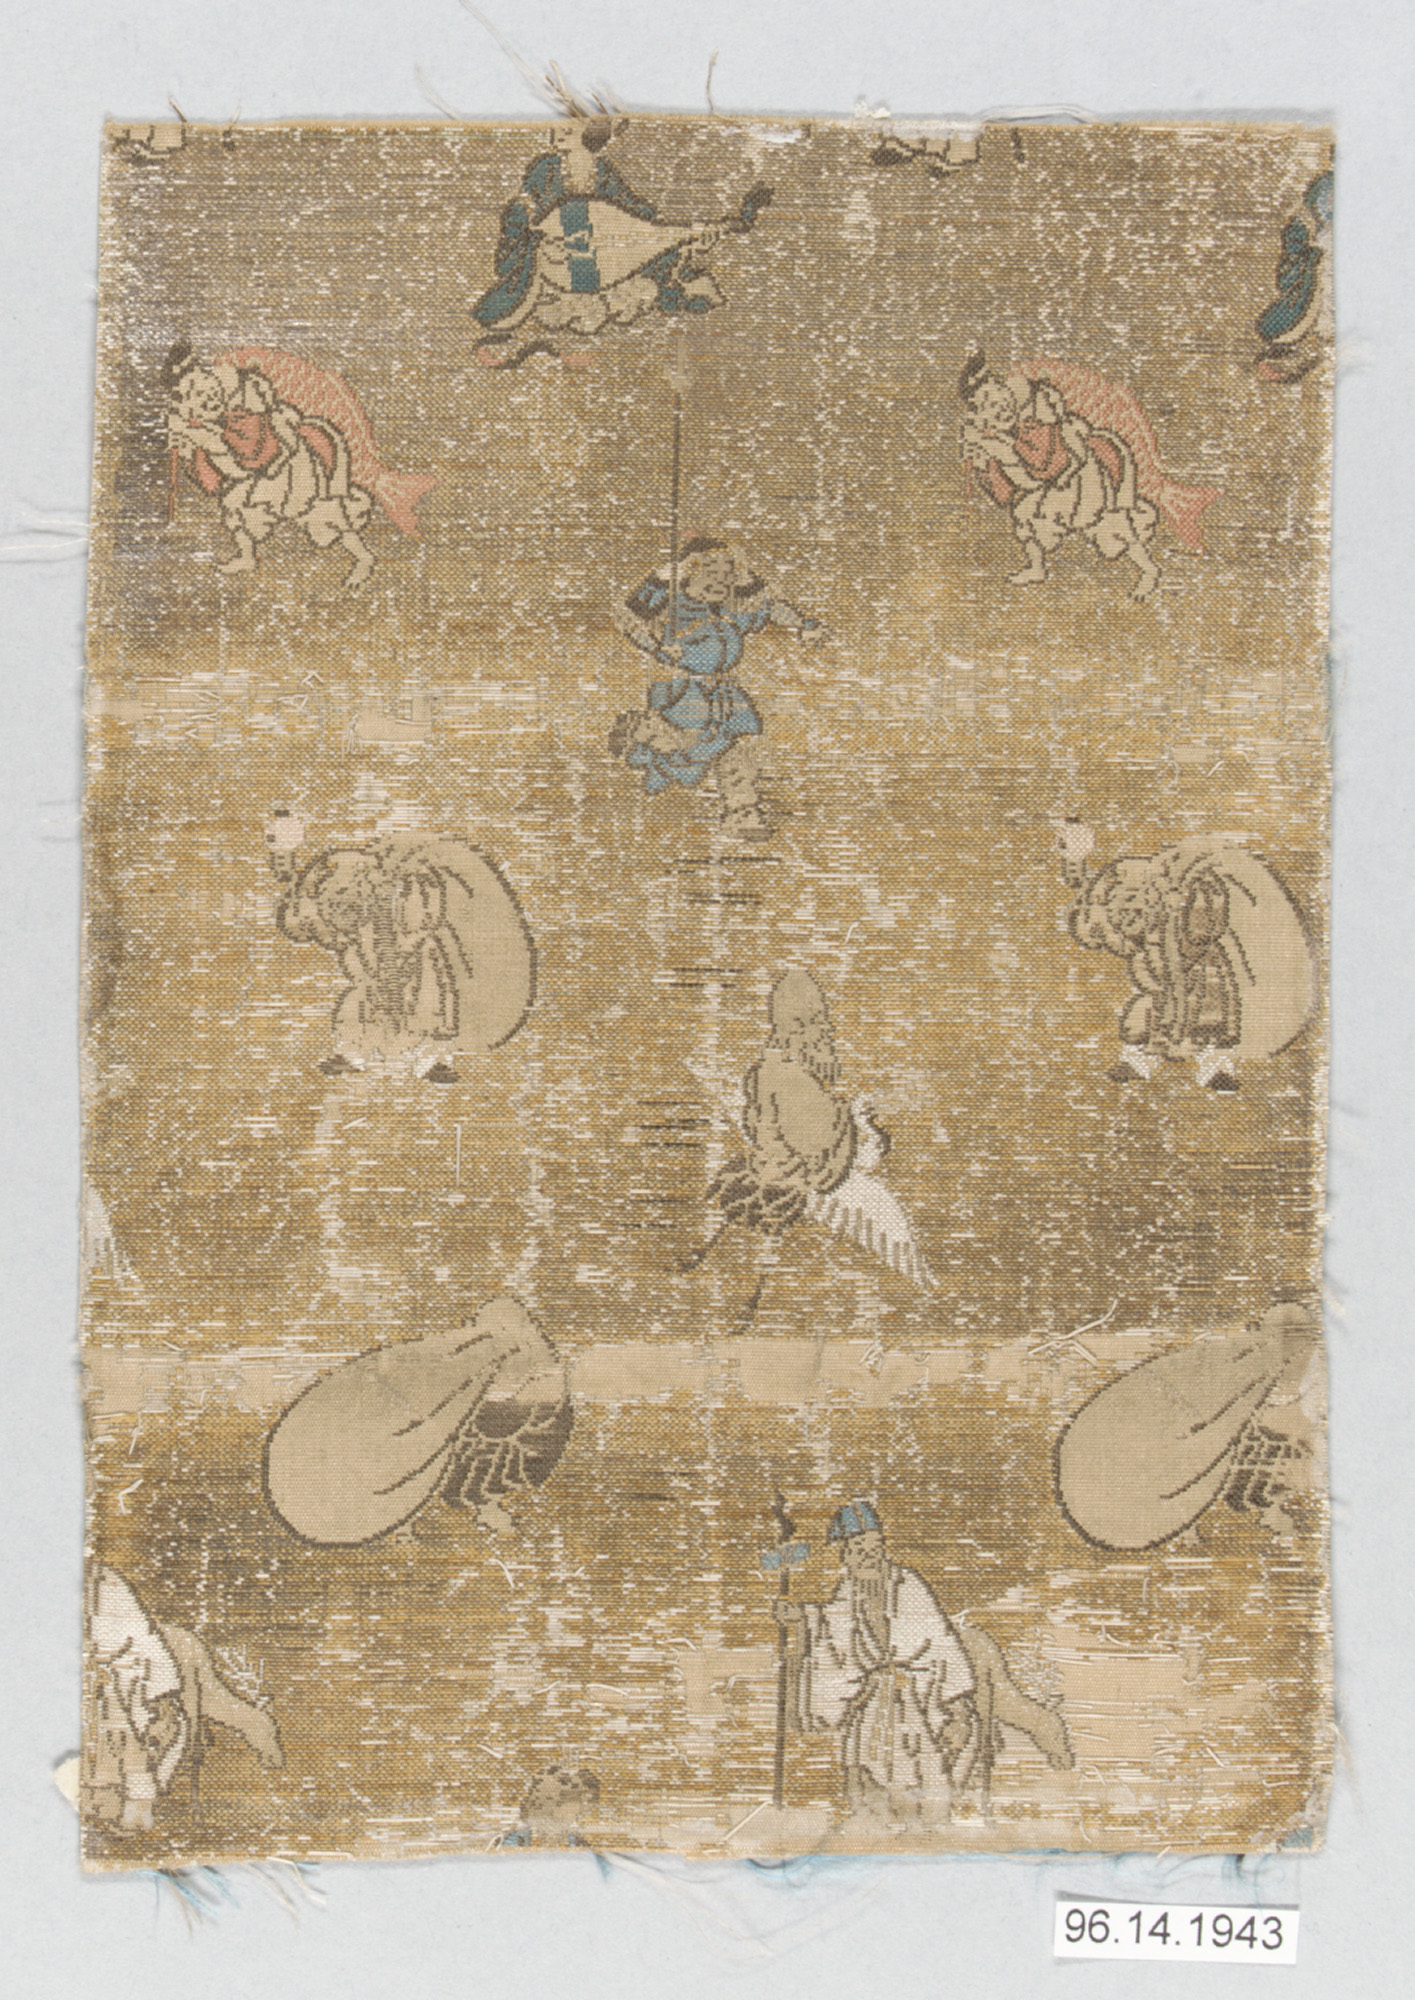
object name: piece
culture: japanese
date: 1701-1900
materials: metal thread, silk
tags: human figures